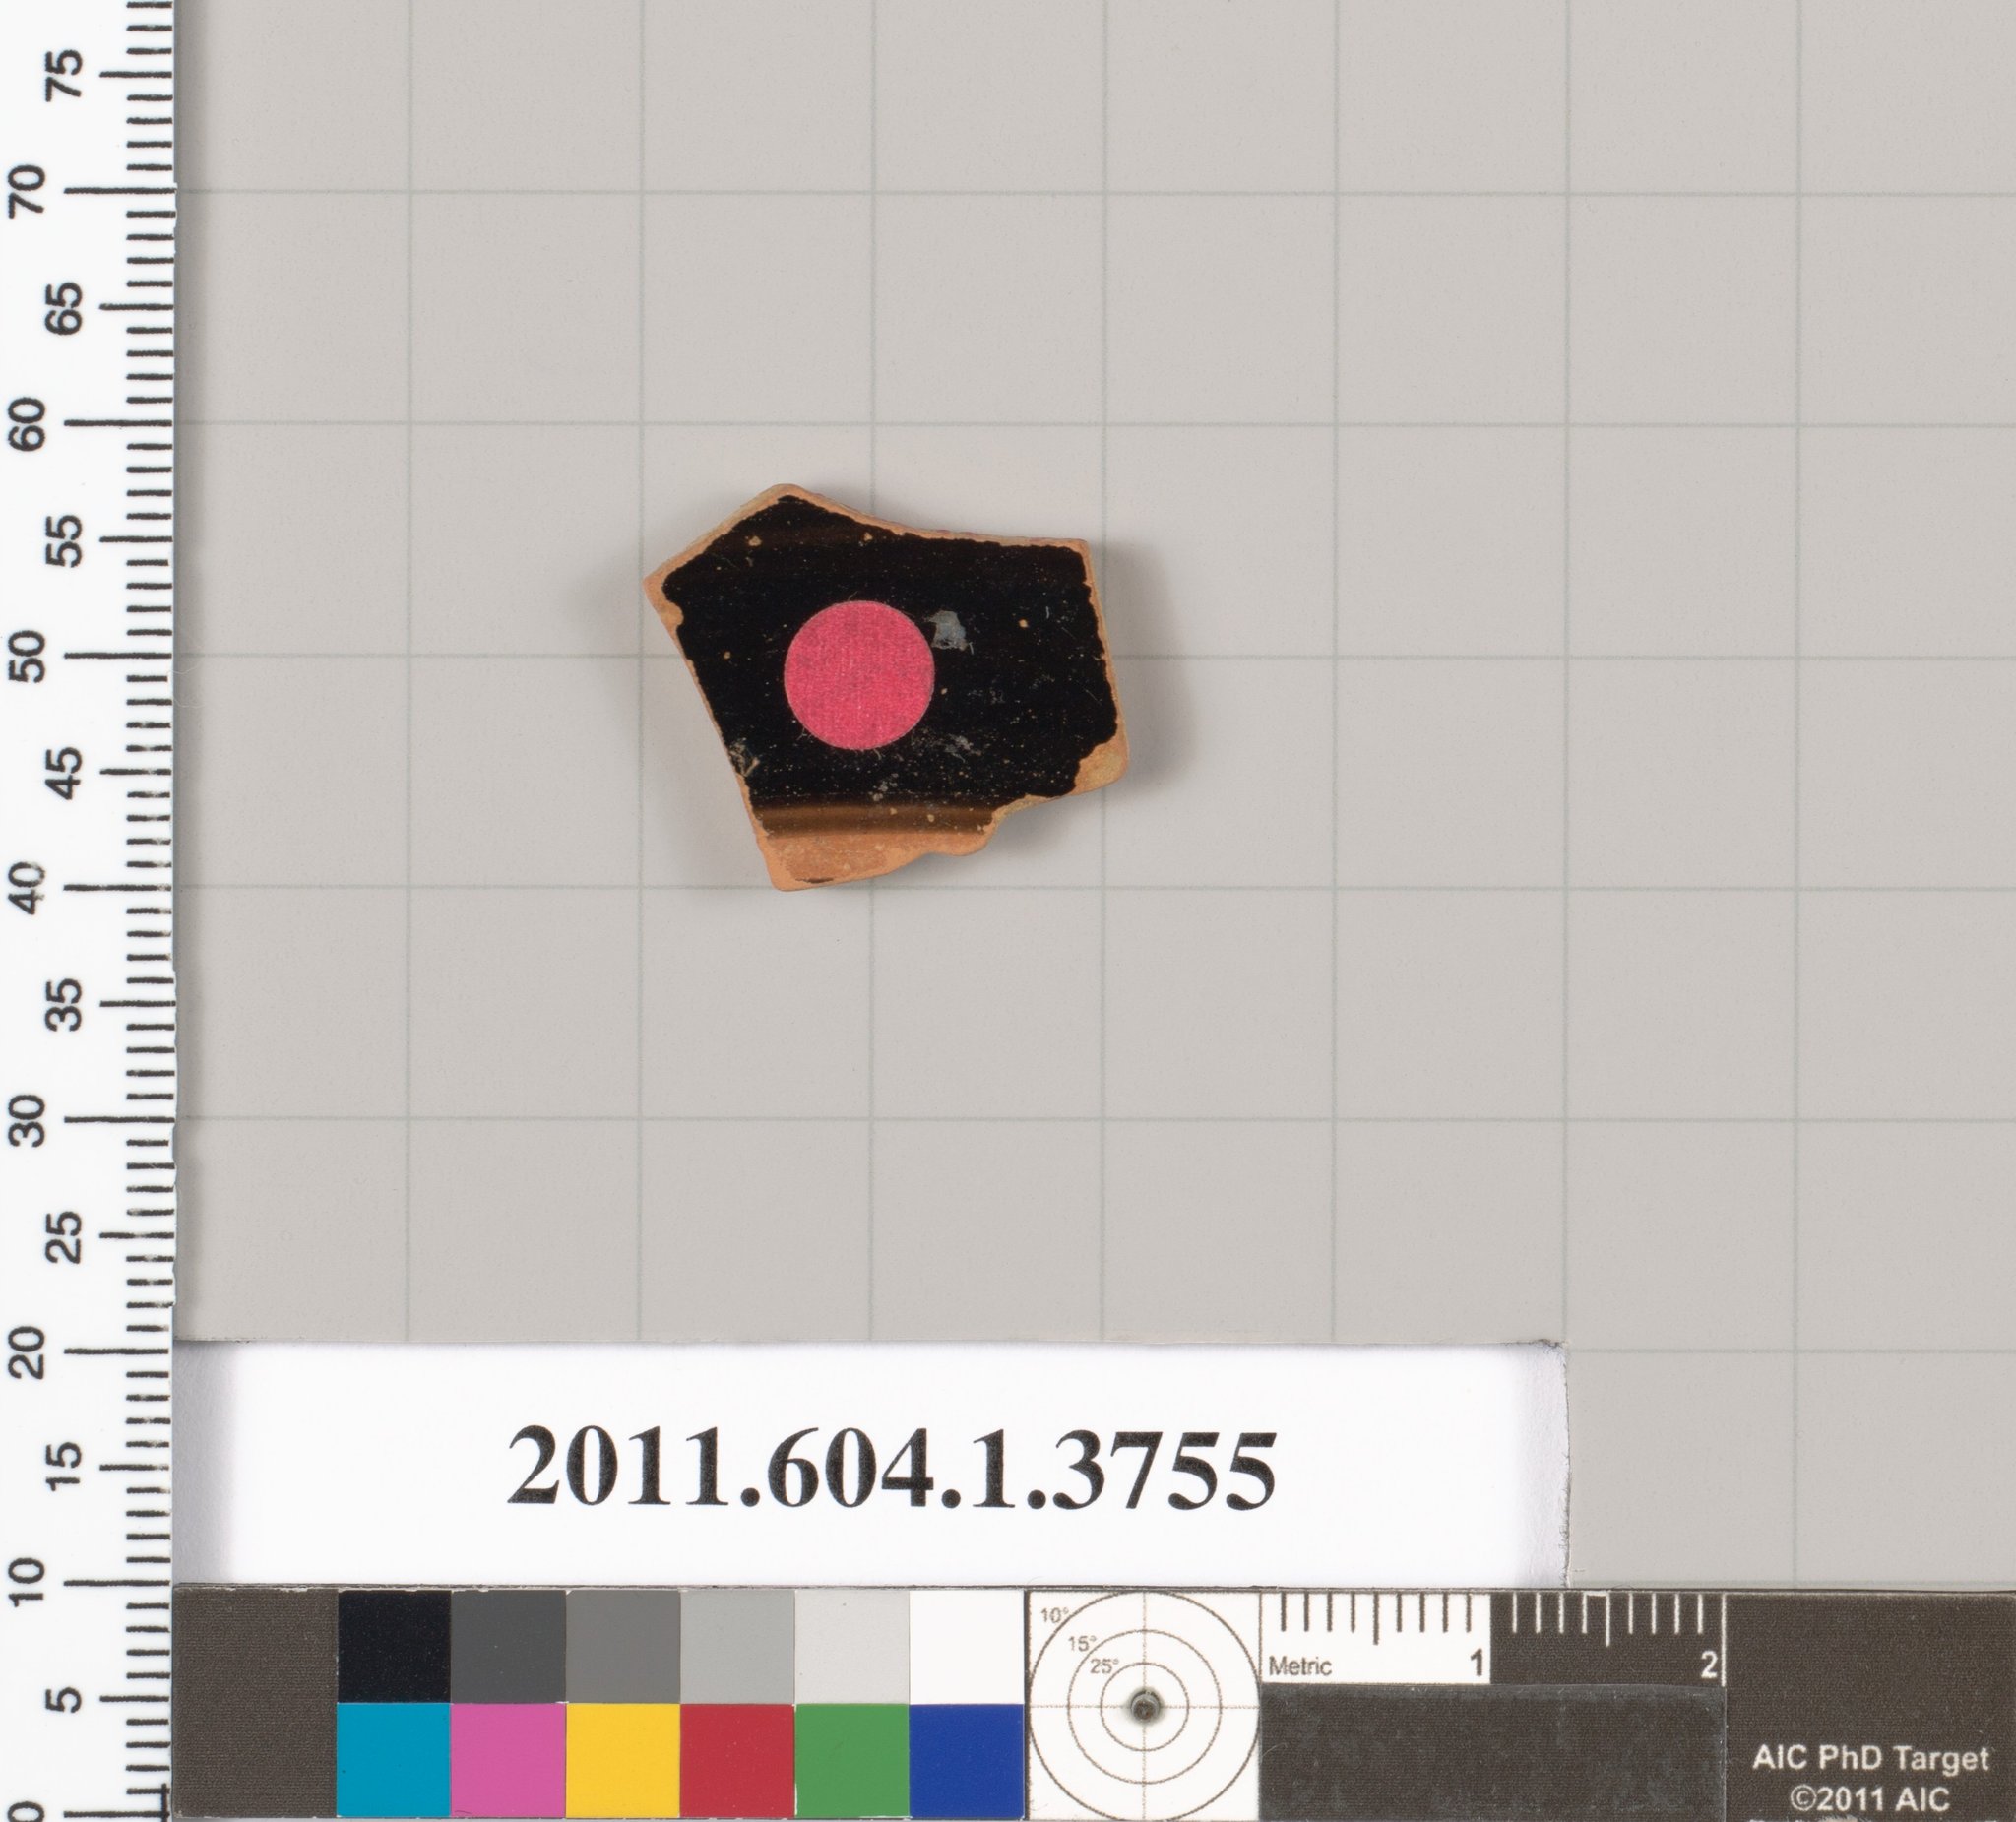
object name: kylix fragment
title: Terracotta fragment of a kylix (drinking cup)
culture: greek, attic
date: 475-451 BCE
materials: terracotta